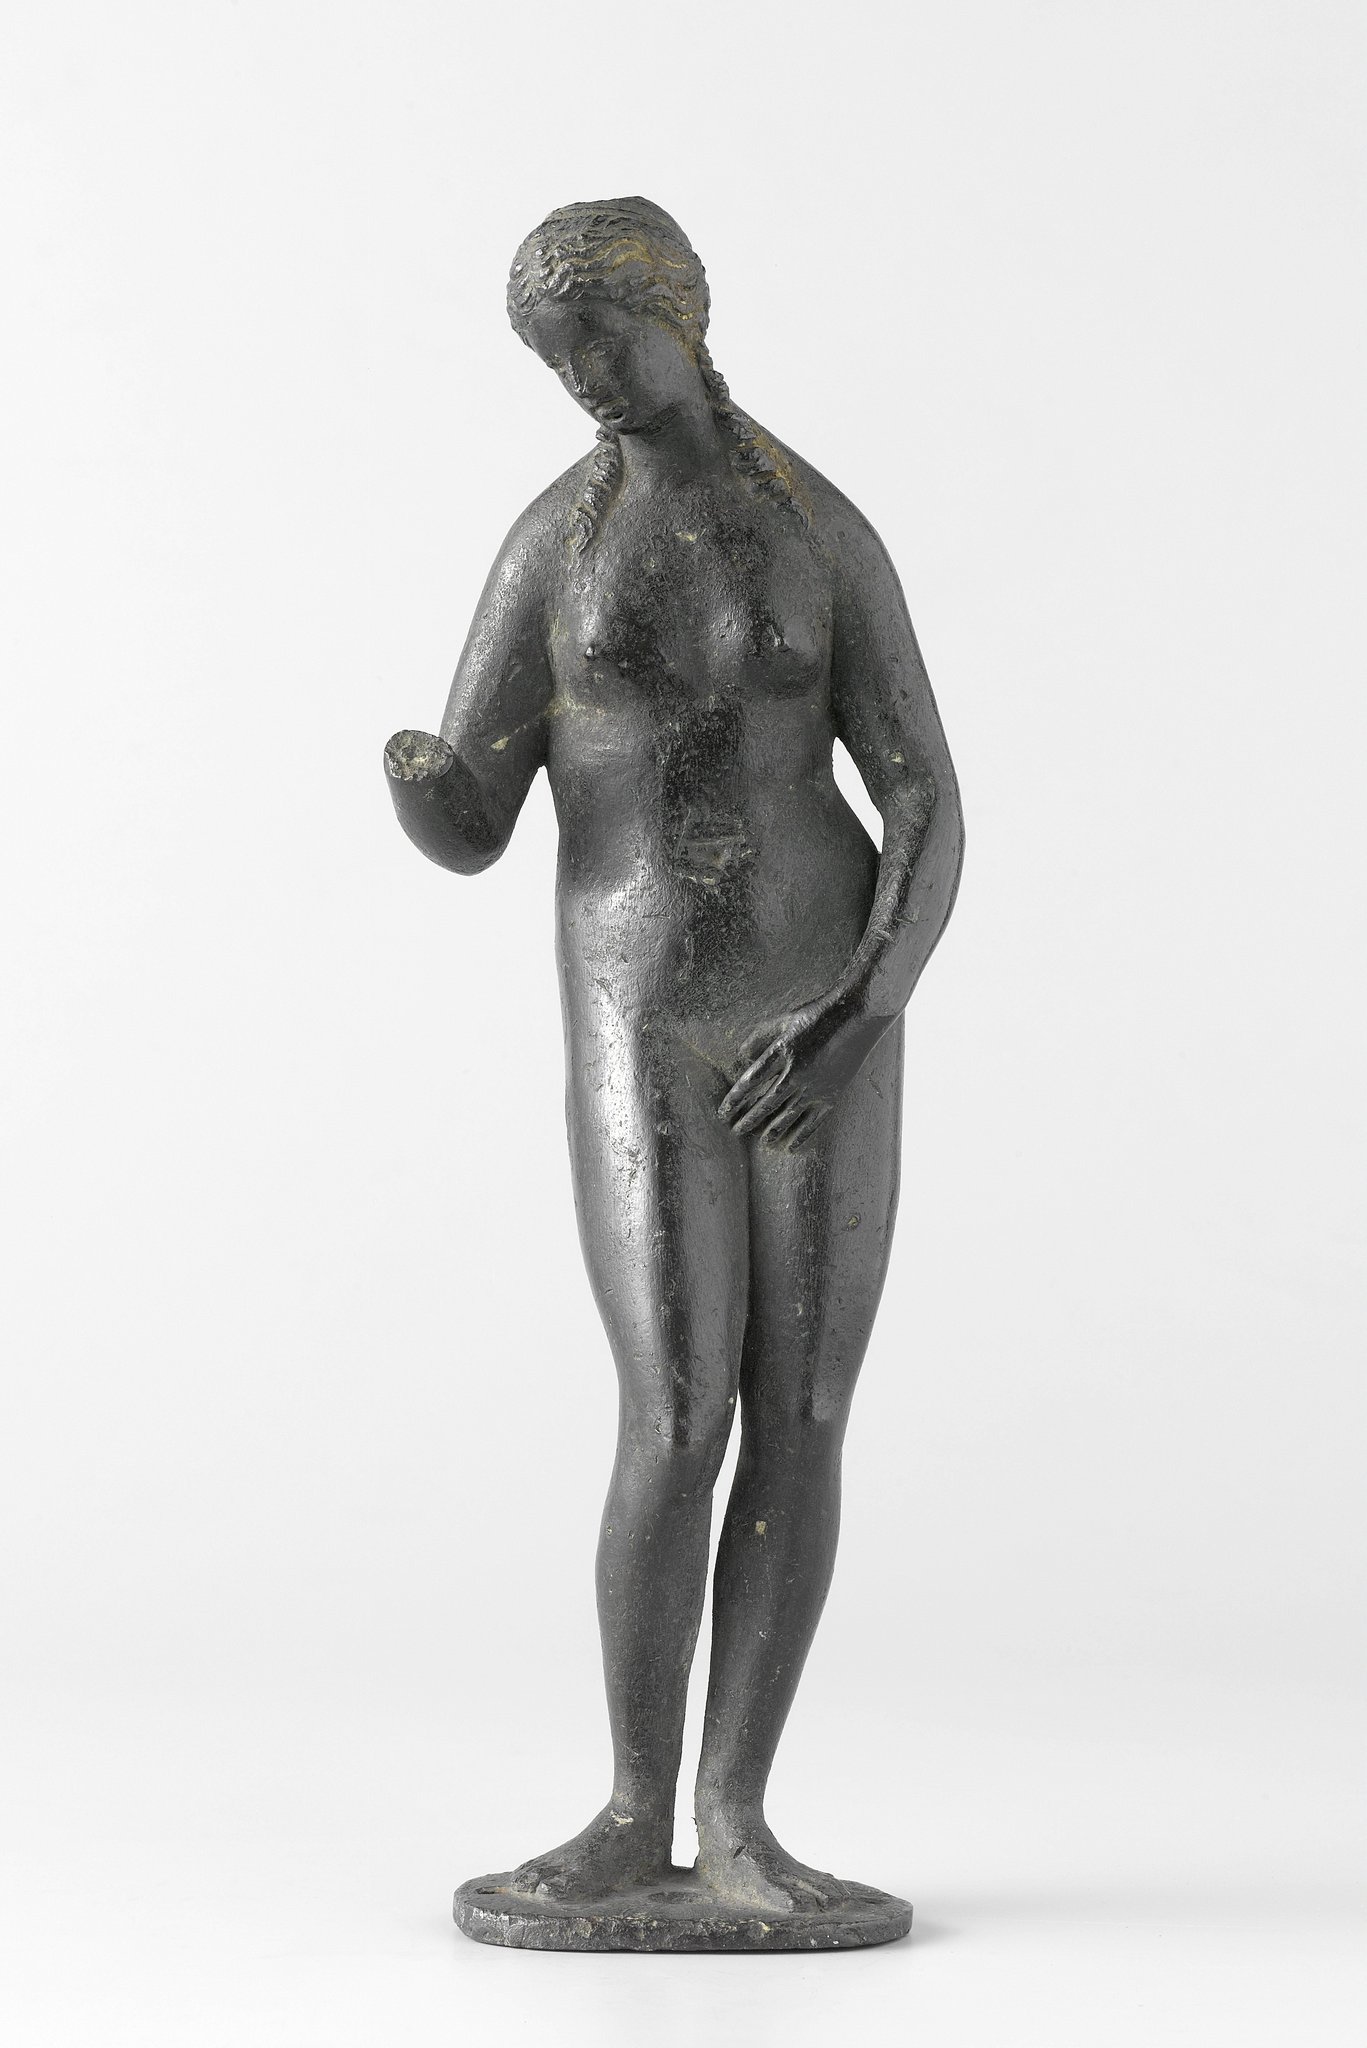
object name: sculpture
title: Venus pudica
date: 1500-1550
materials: bronze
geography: venice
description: Venus Pudica. Bronze. Mantua or Padua, c. 1500.